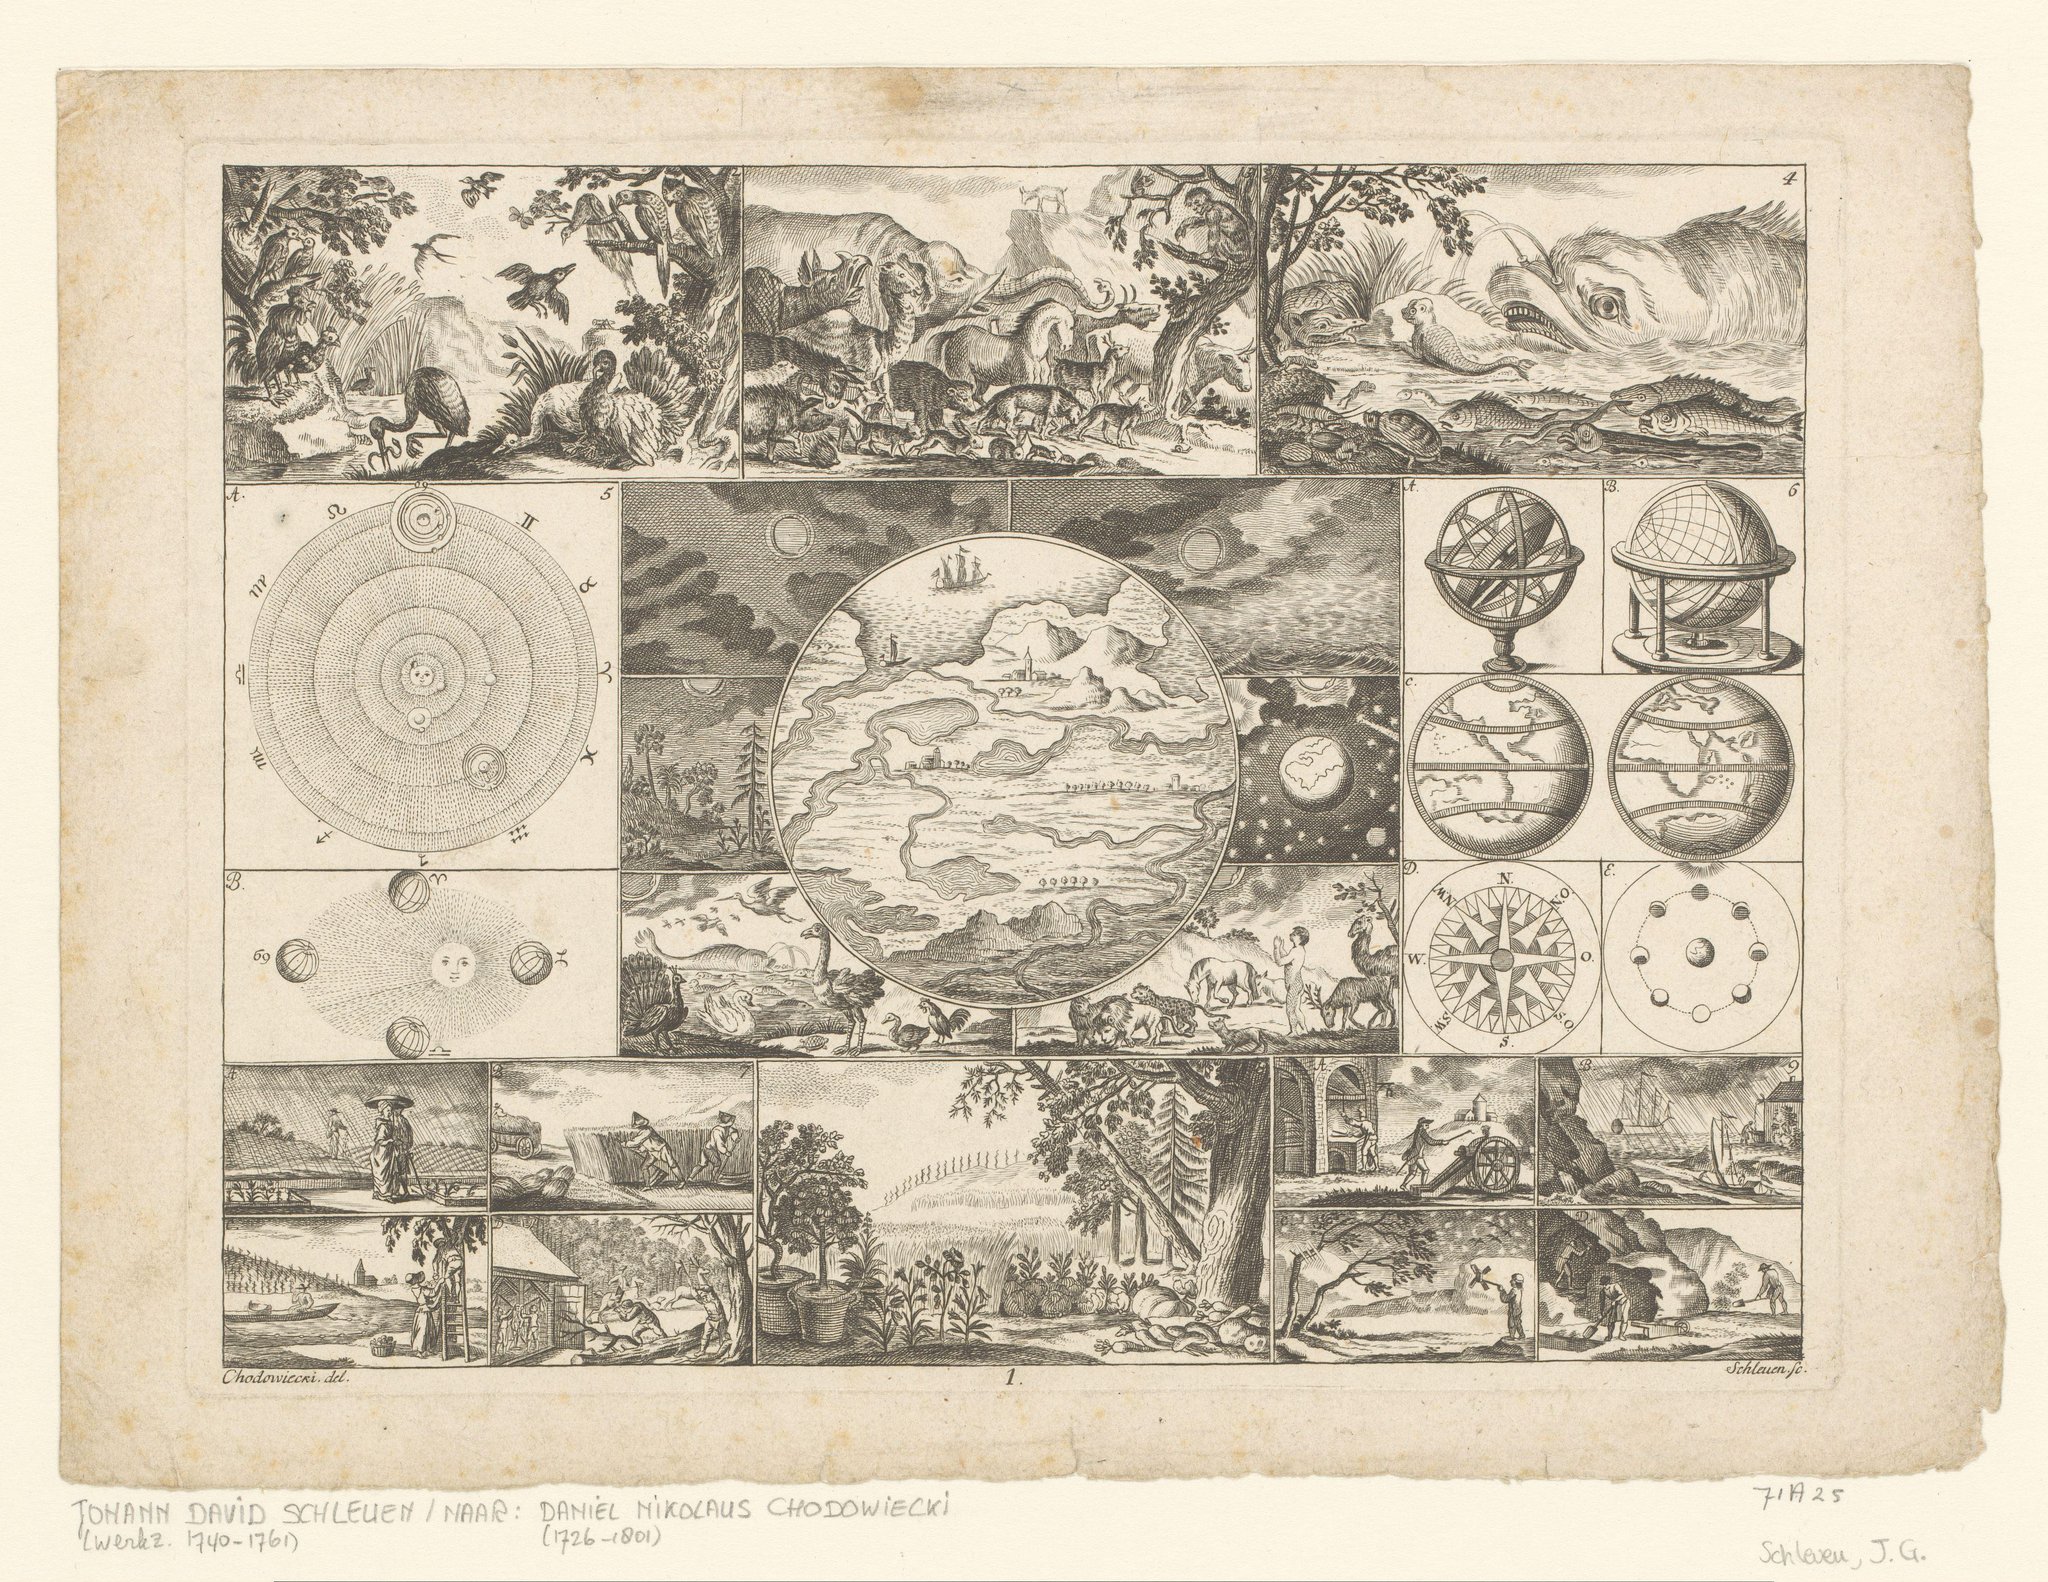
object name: print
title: Bilder-Akademie für die Jugend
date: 1784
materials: paper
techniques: engraving, etching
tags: spheres ~ heavens, globe, the six days of creation (genesis 1:3-25)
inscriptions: collector's mark: Lugt 2228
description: Maakt deel uit van een serie encyclopedische prenten door verschillende kunstenaars naar ontwerp van Daniel Nikolaus Chodowiecki bij Johann Sigmund Stoy's 'Bilder-Akademie für die Jugend', uitgegeven te Neurenberg in 1784. De prenten waren bedoeld voor kinderen om uit te knippen, op kaarten te plakken en vervolgens op logische wijze te rangschikken (zie Heesen, Anke te. The World in a Box: The Story of an Eighteenth-Century Picture Encyclopedia. Chicago: University of Chicago Press, 2002).